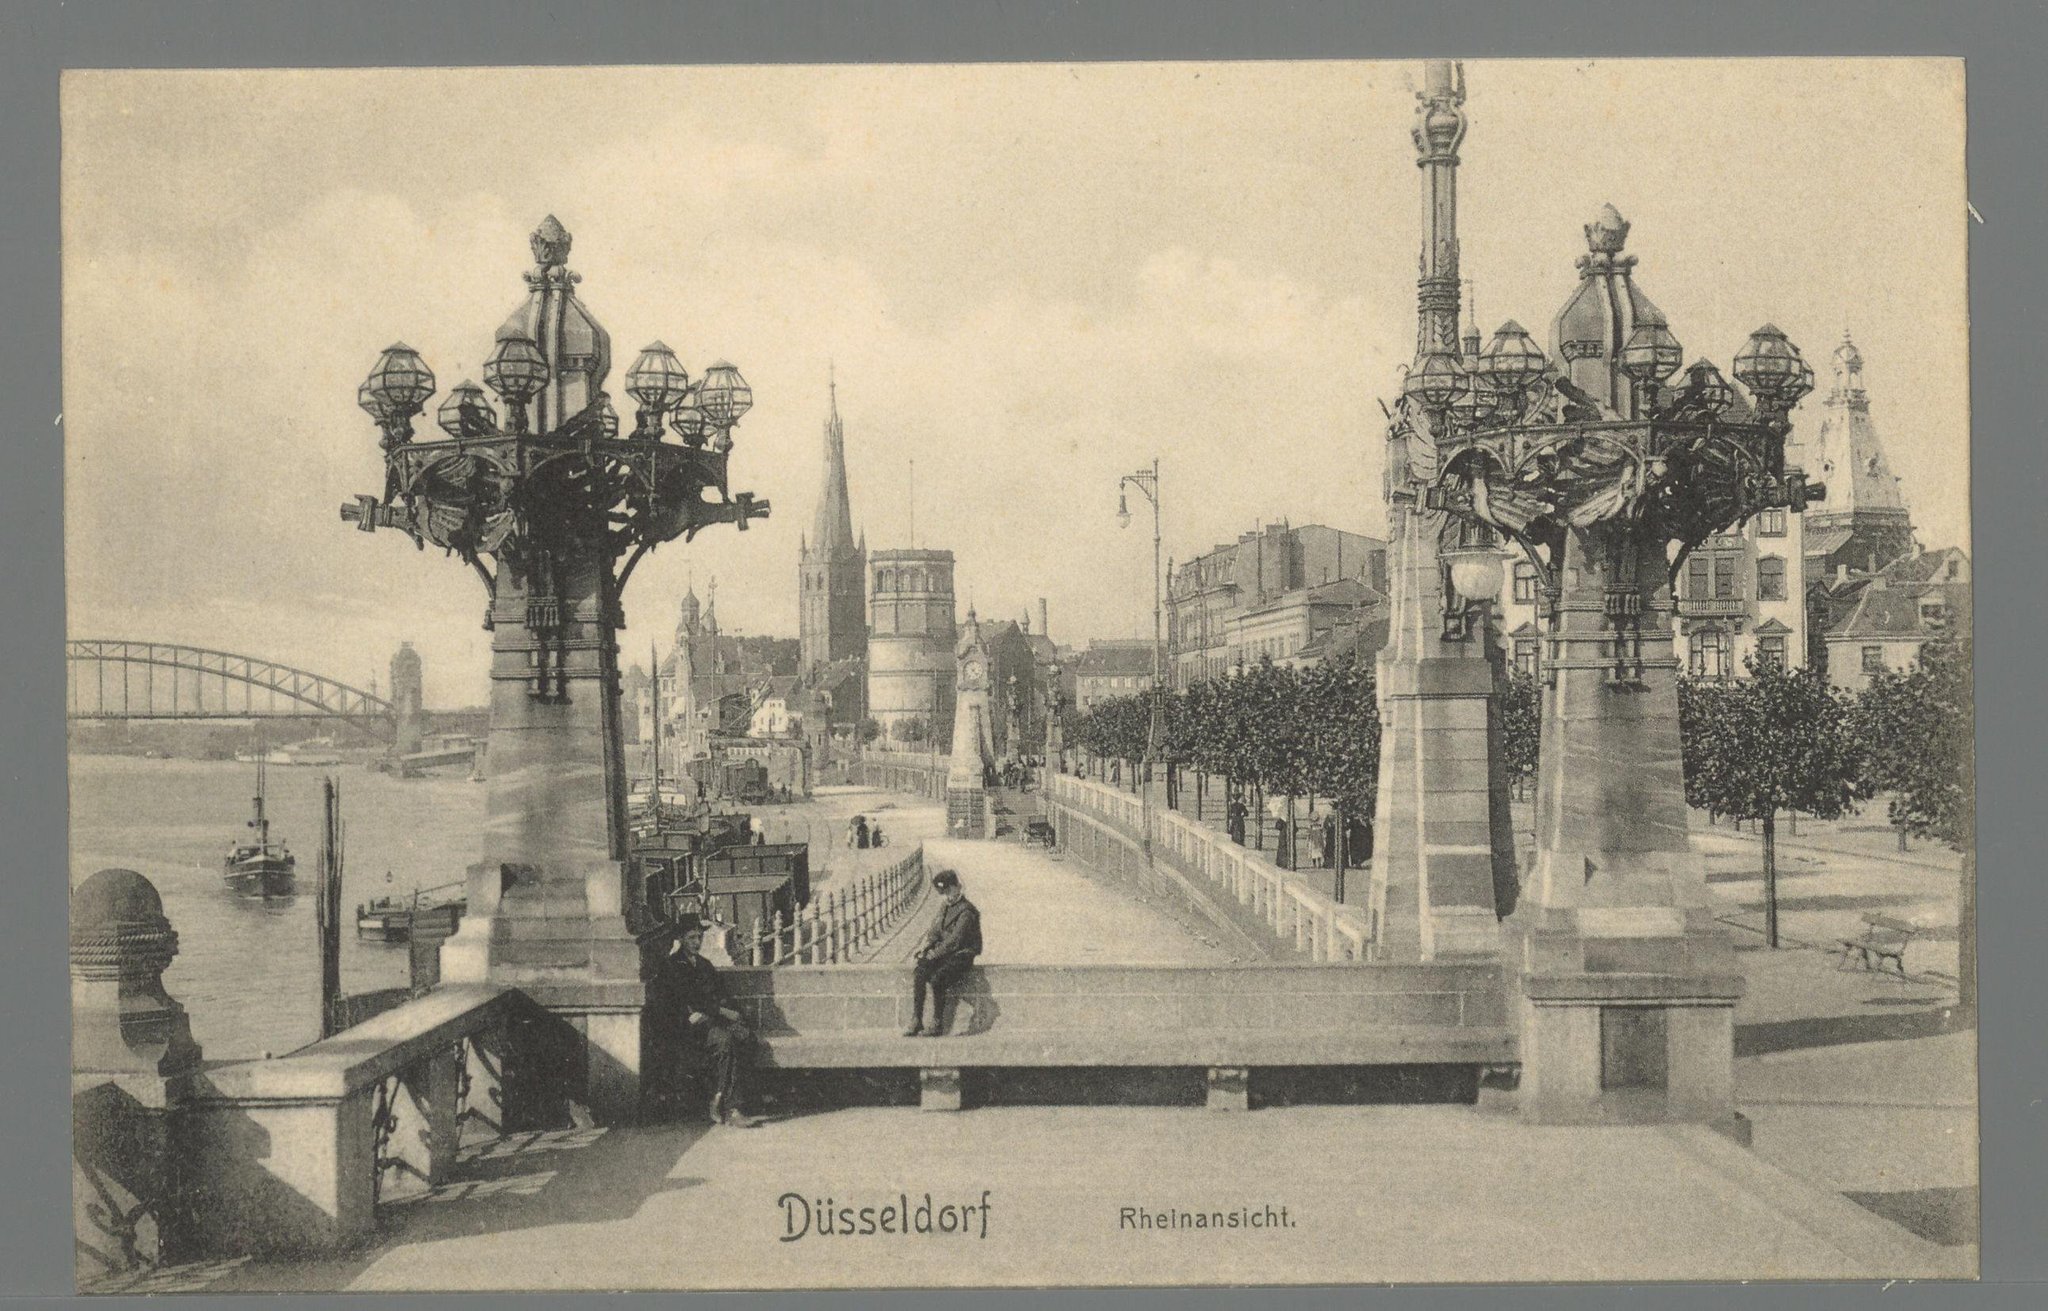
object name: ansichtkaart, prentbriefkaart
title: Düsseldorf. Rheinansicht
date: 1905-1930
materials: cardboard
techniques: photograph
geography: dusseldorf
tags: church (exterior), canals, waters (in city), bridge in city across river, canal, etc., quay